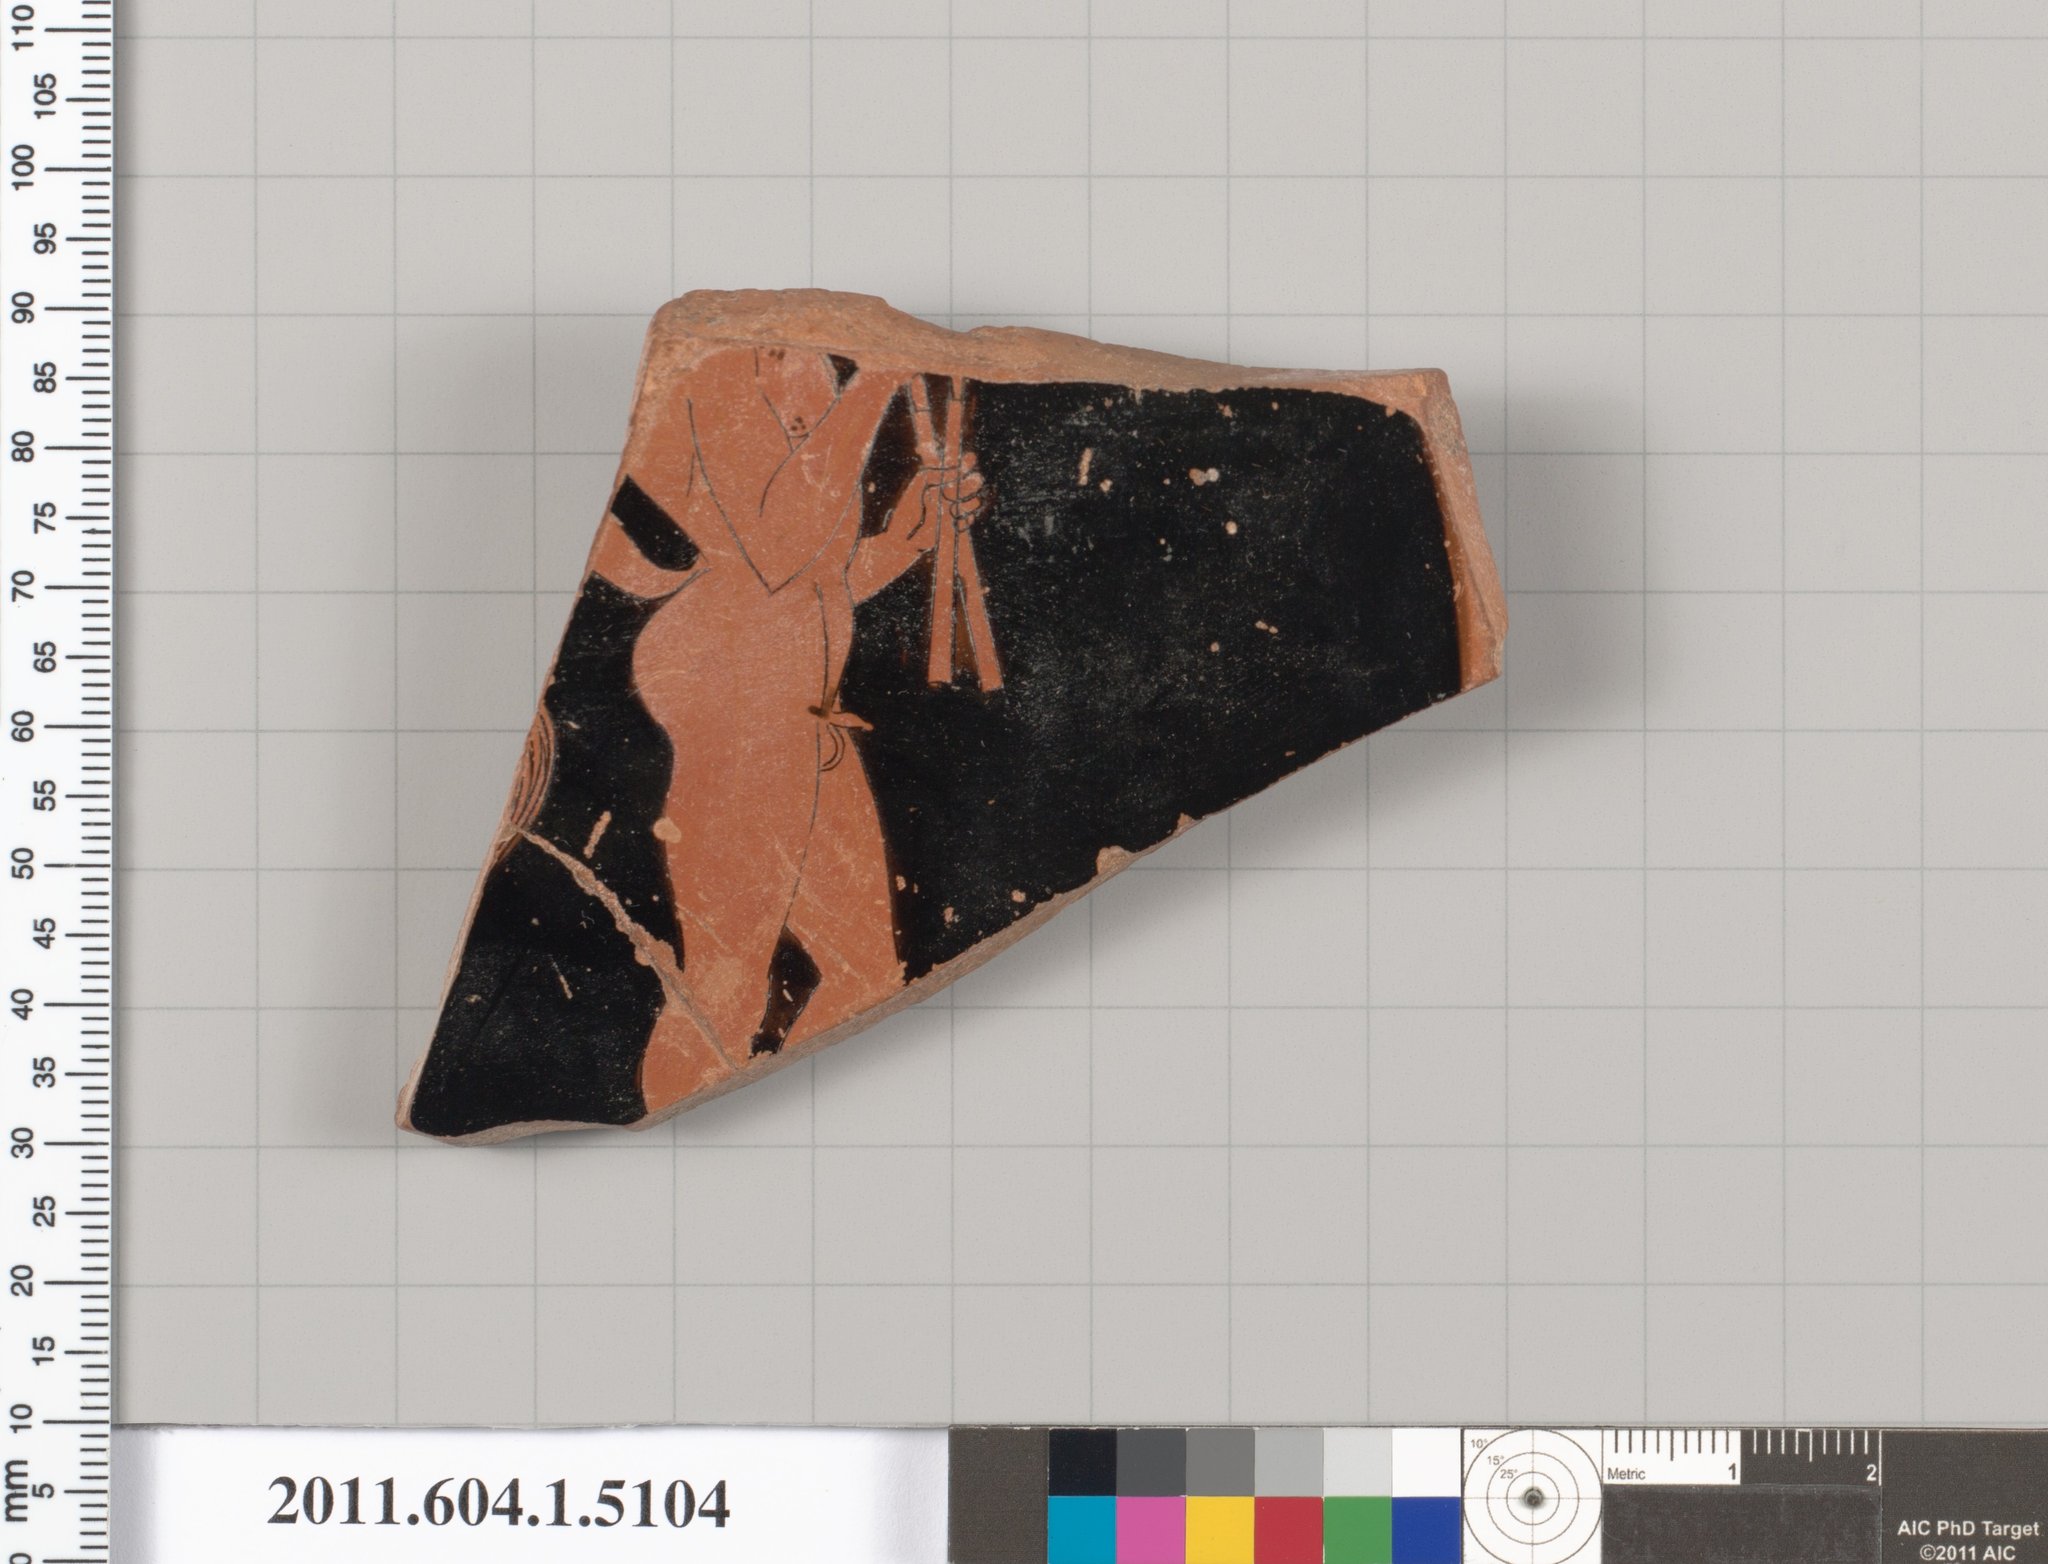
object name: kylix fragment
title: Terracotta fragment of a kylix (drinking cup)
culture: greek, attic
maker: akestorides painter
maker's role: artist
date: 470-460 BCE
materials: terracotta